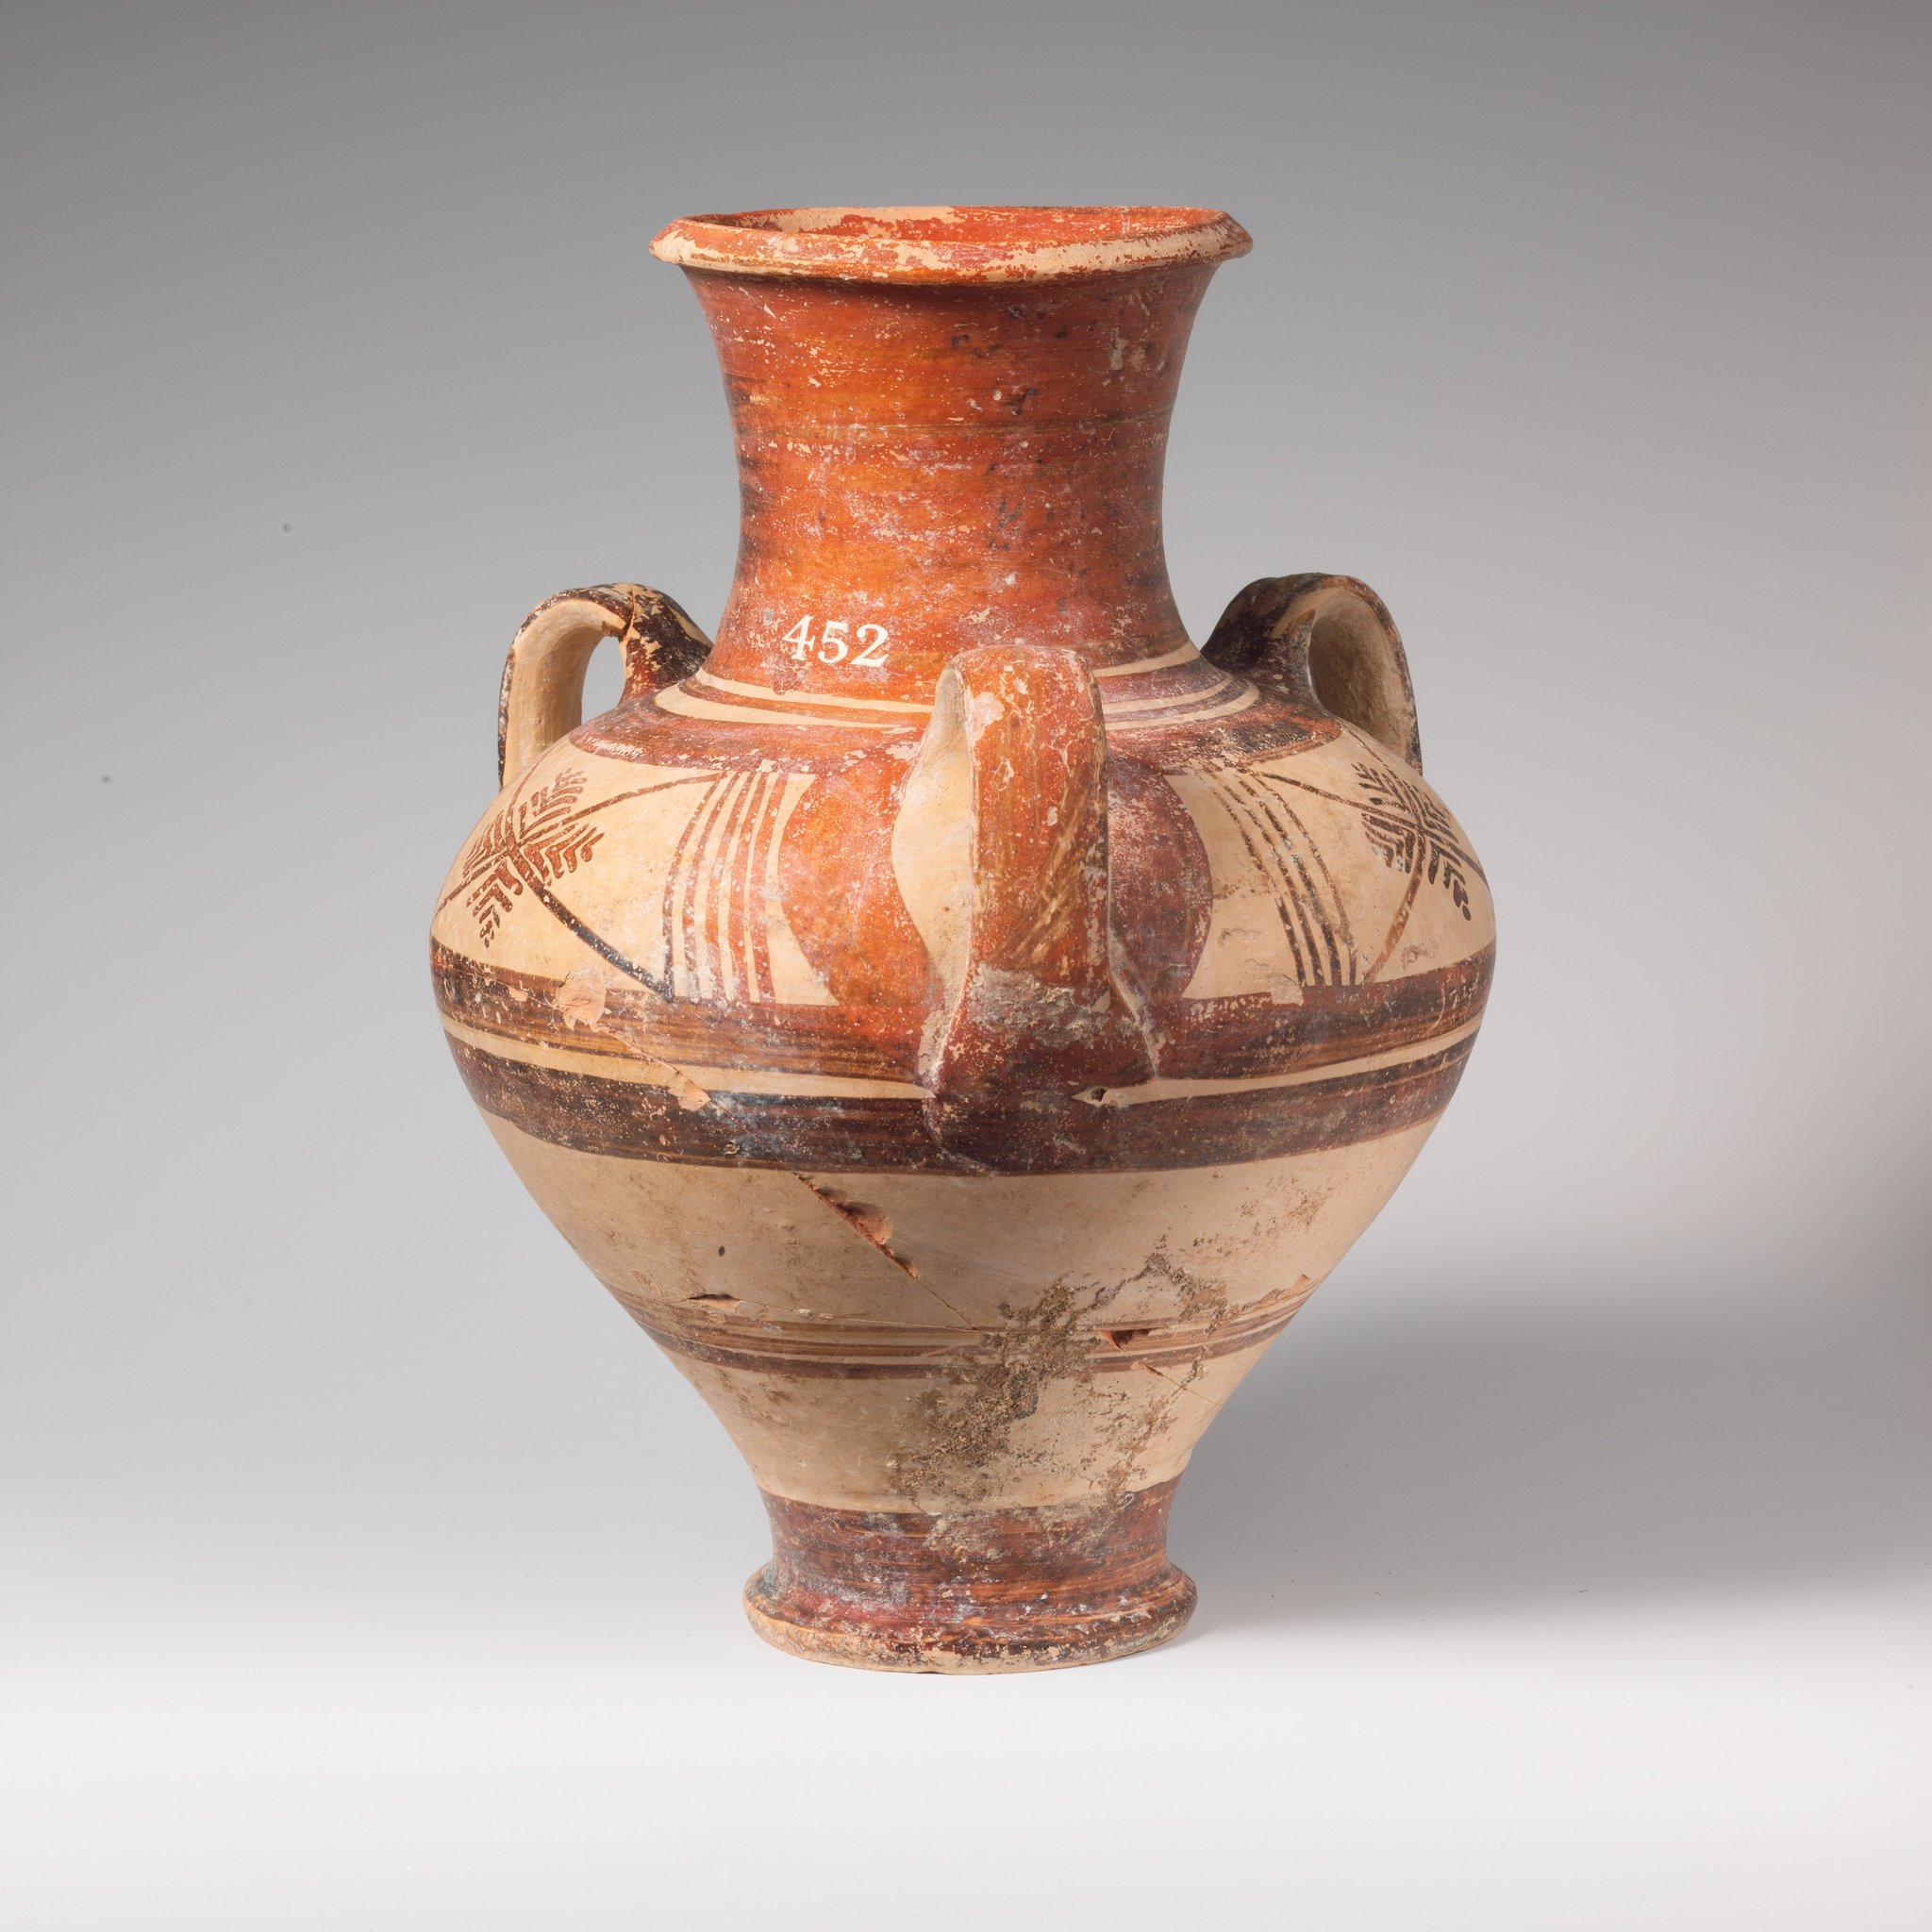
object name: pithoid jar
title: Terracotta pithoid jar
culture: mycenaean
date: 1300-1190 BCE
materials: terracotta